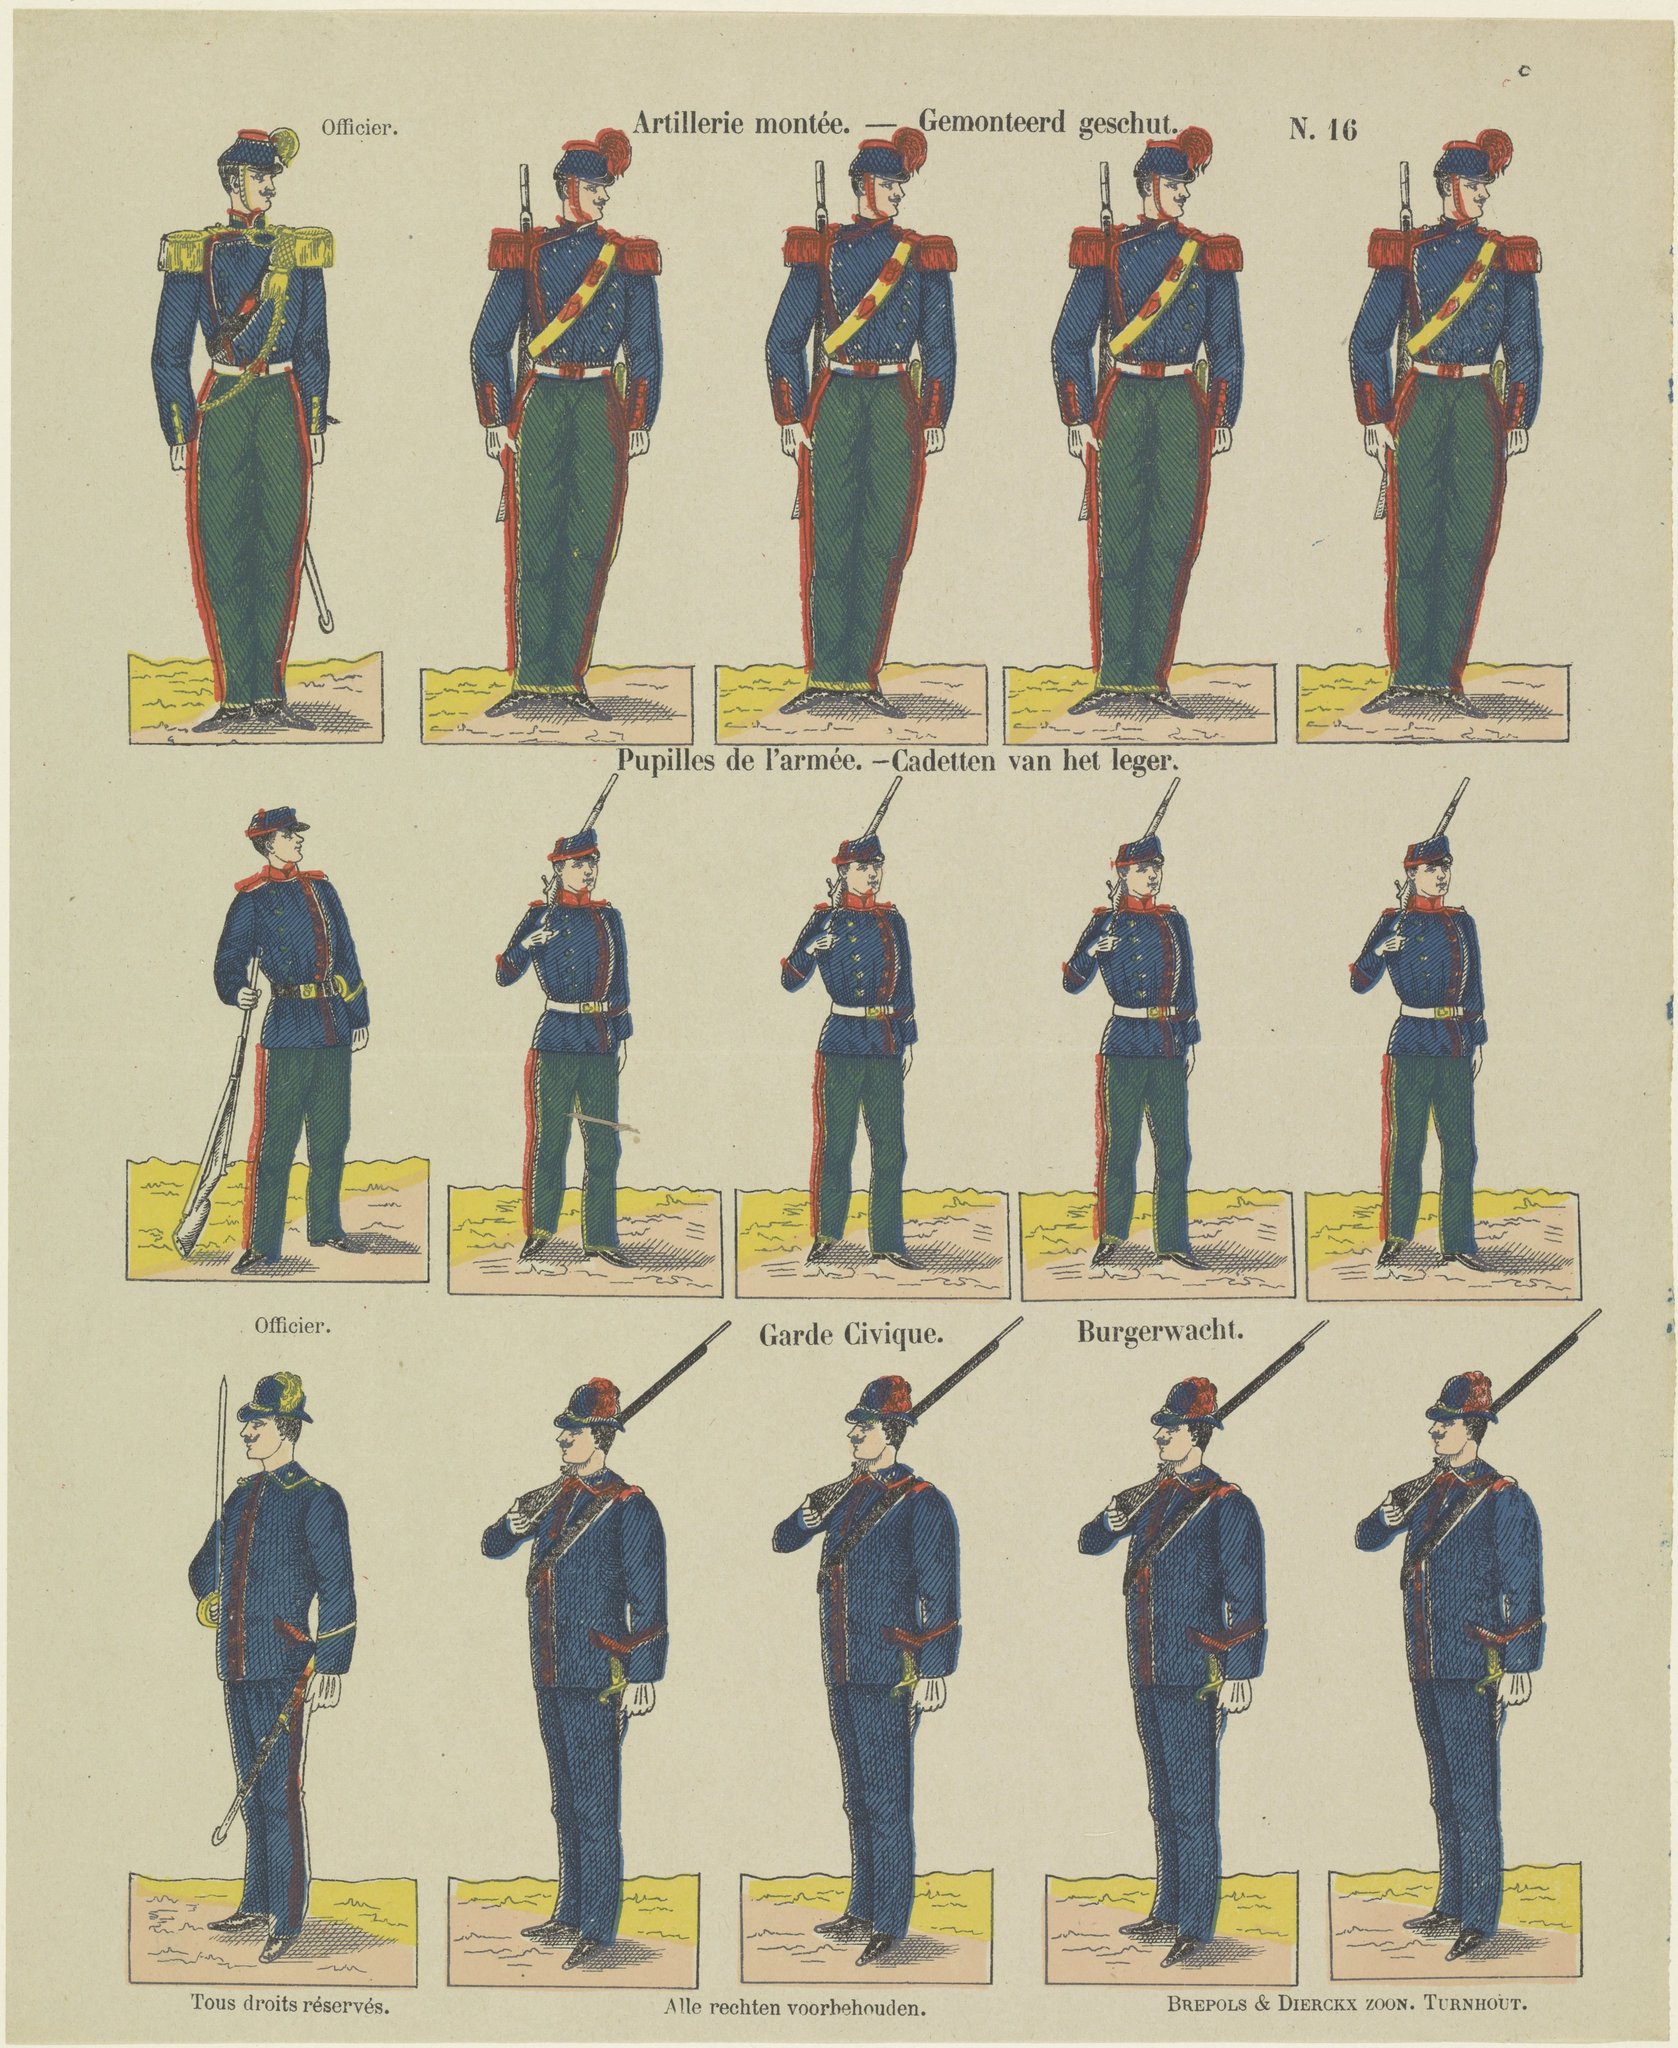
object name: popular print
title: Artillerie montée / Gemonteerd geschut / Pupilles de l'armée / Cadetten van het leger / Garde civique / Burgerwacht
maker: Anonymous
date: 1833-1911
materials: paper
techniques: lithograph, letterpress printing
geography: turnhout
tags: the soldier; the soldier's life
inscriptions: collector's mark: Lugt 2760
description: Blad met 3 horizontale rijen met in totaal 15 voorstellingen van officieren en militairen met geweren. Genummerd rechtsboven: N. 16.